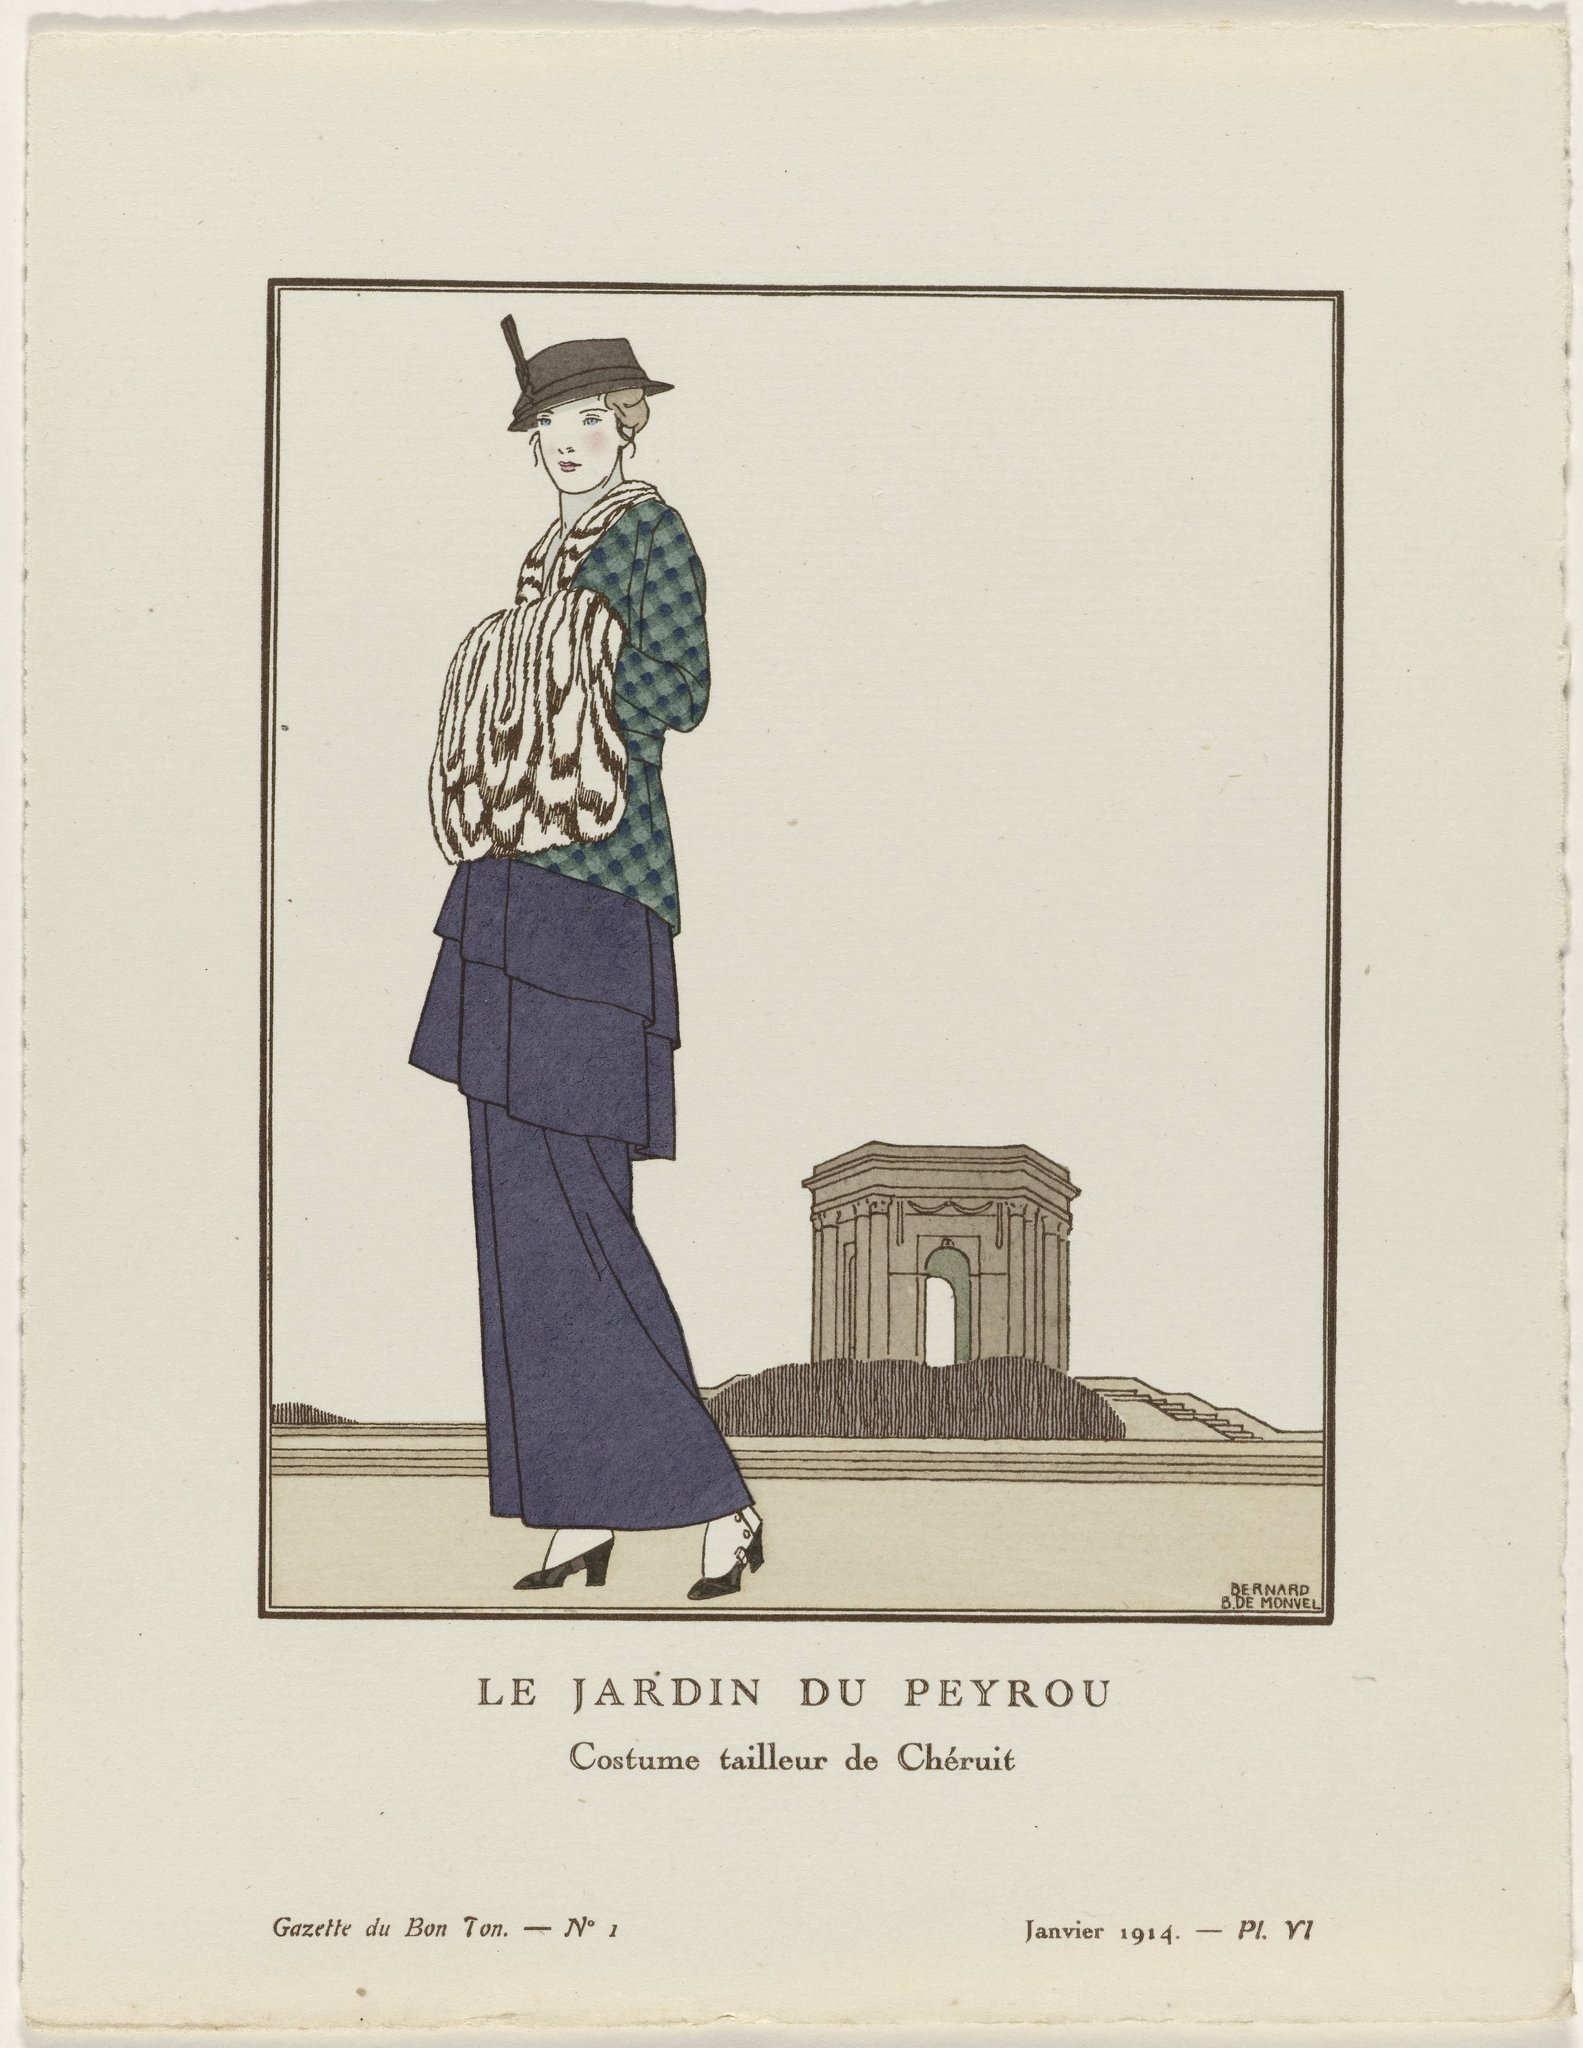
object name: fashion print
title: Gazette du Bon Ton, 1914 - No. 1, Pl. VI: Le Jardin de Peyrou / Costume tailleur de Chéruit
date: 1914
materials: paper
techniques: hand coloring, letterpress printing, lithograph, pochoir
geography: théâtre des folies-marigny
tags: muff, head-gear (+ women's clothes), fashion plates, dress, gown (+ women's clothes), garden buildings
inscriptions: date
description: Staande vrouw in tailleur van Chéruit. Planche VI uit Gazette du Bon Ton 1914, No. 1. Uitleg over de kleding op pagina "Explication des Planches".